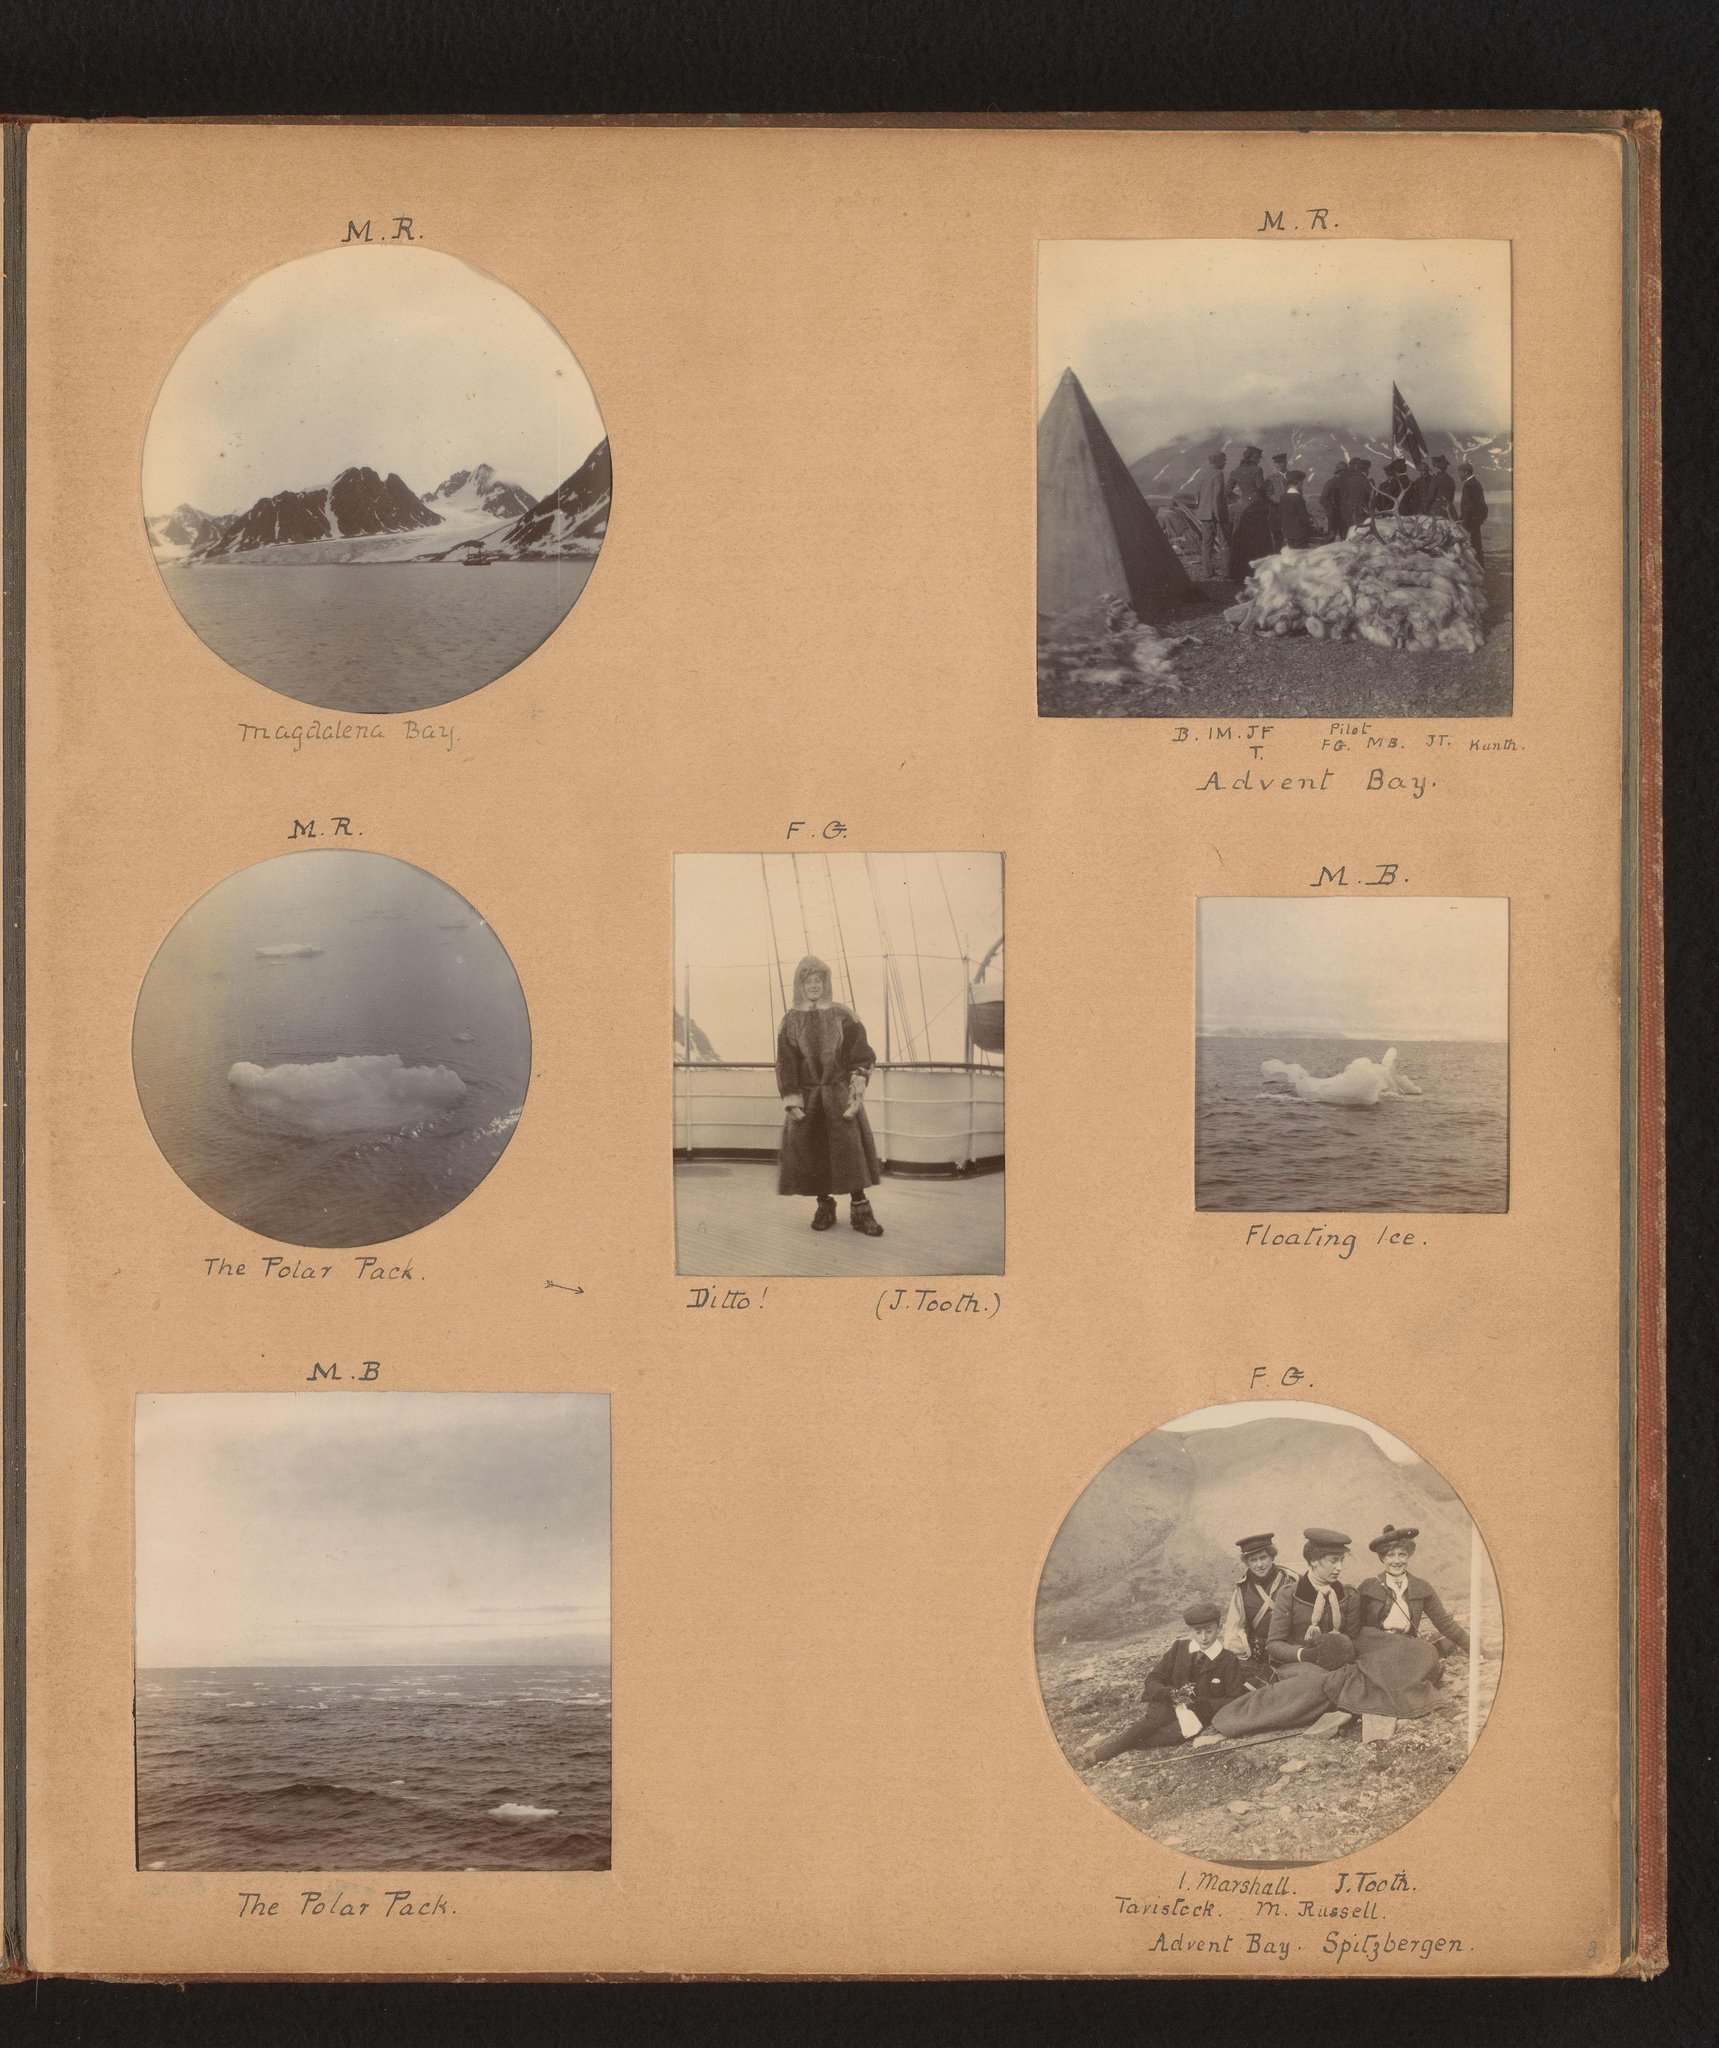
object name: album leaf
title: Zeven foto's van ijsschotsen en een reisgezelschap op Spitsbergen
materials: paper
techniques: gelatin silver print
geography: spitsbergen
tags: j. tooth, f. green (fotograaf), i. marshall, politician, gulf, bay, drift ice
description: Deze foto's maken deel uit van een album.